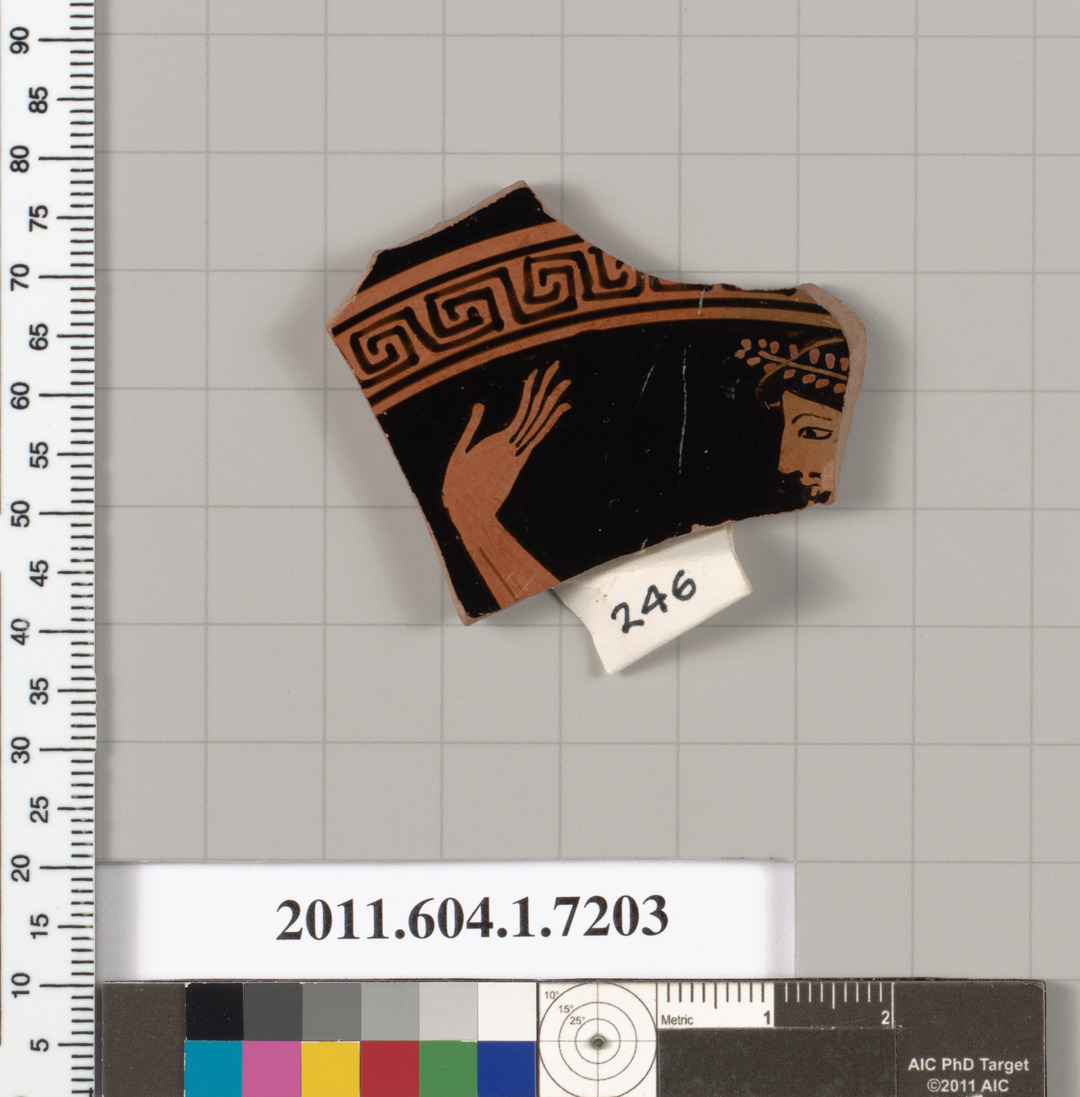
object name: kylix fragment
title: Terracotta fragment of a kylix (drinking cup)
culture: greek, attic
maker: makron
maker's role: artist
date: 500-480 BCE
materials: terracotta